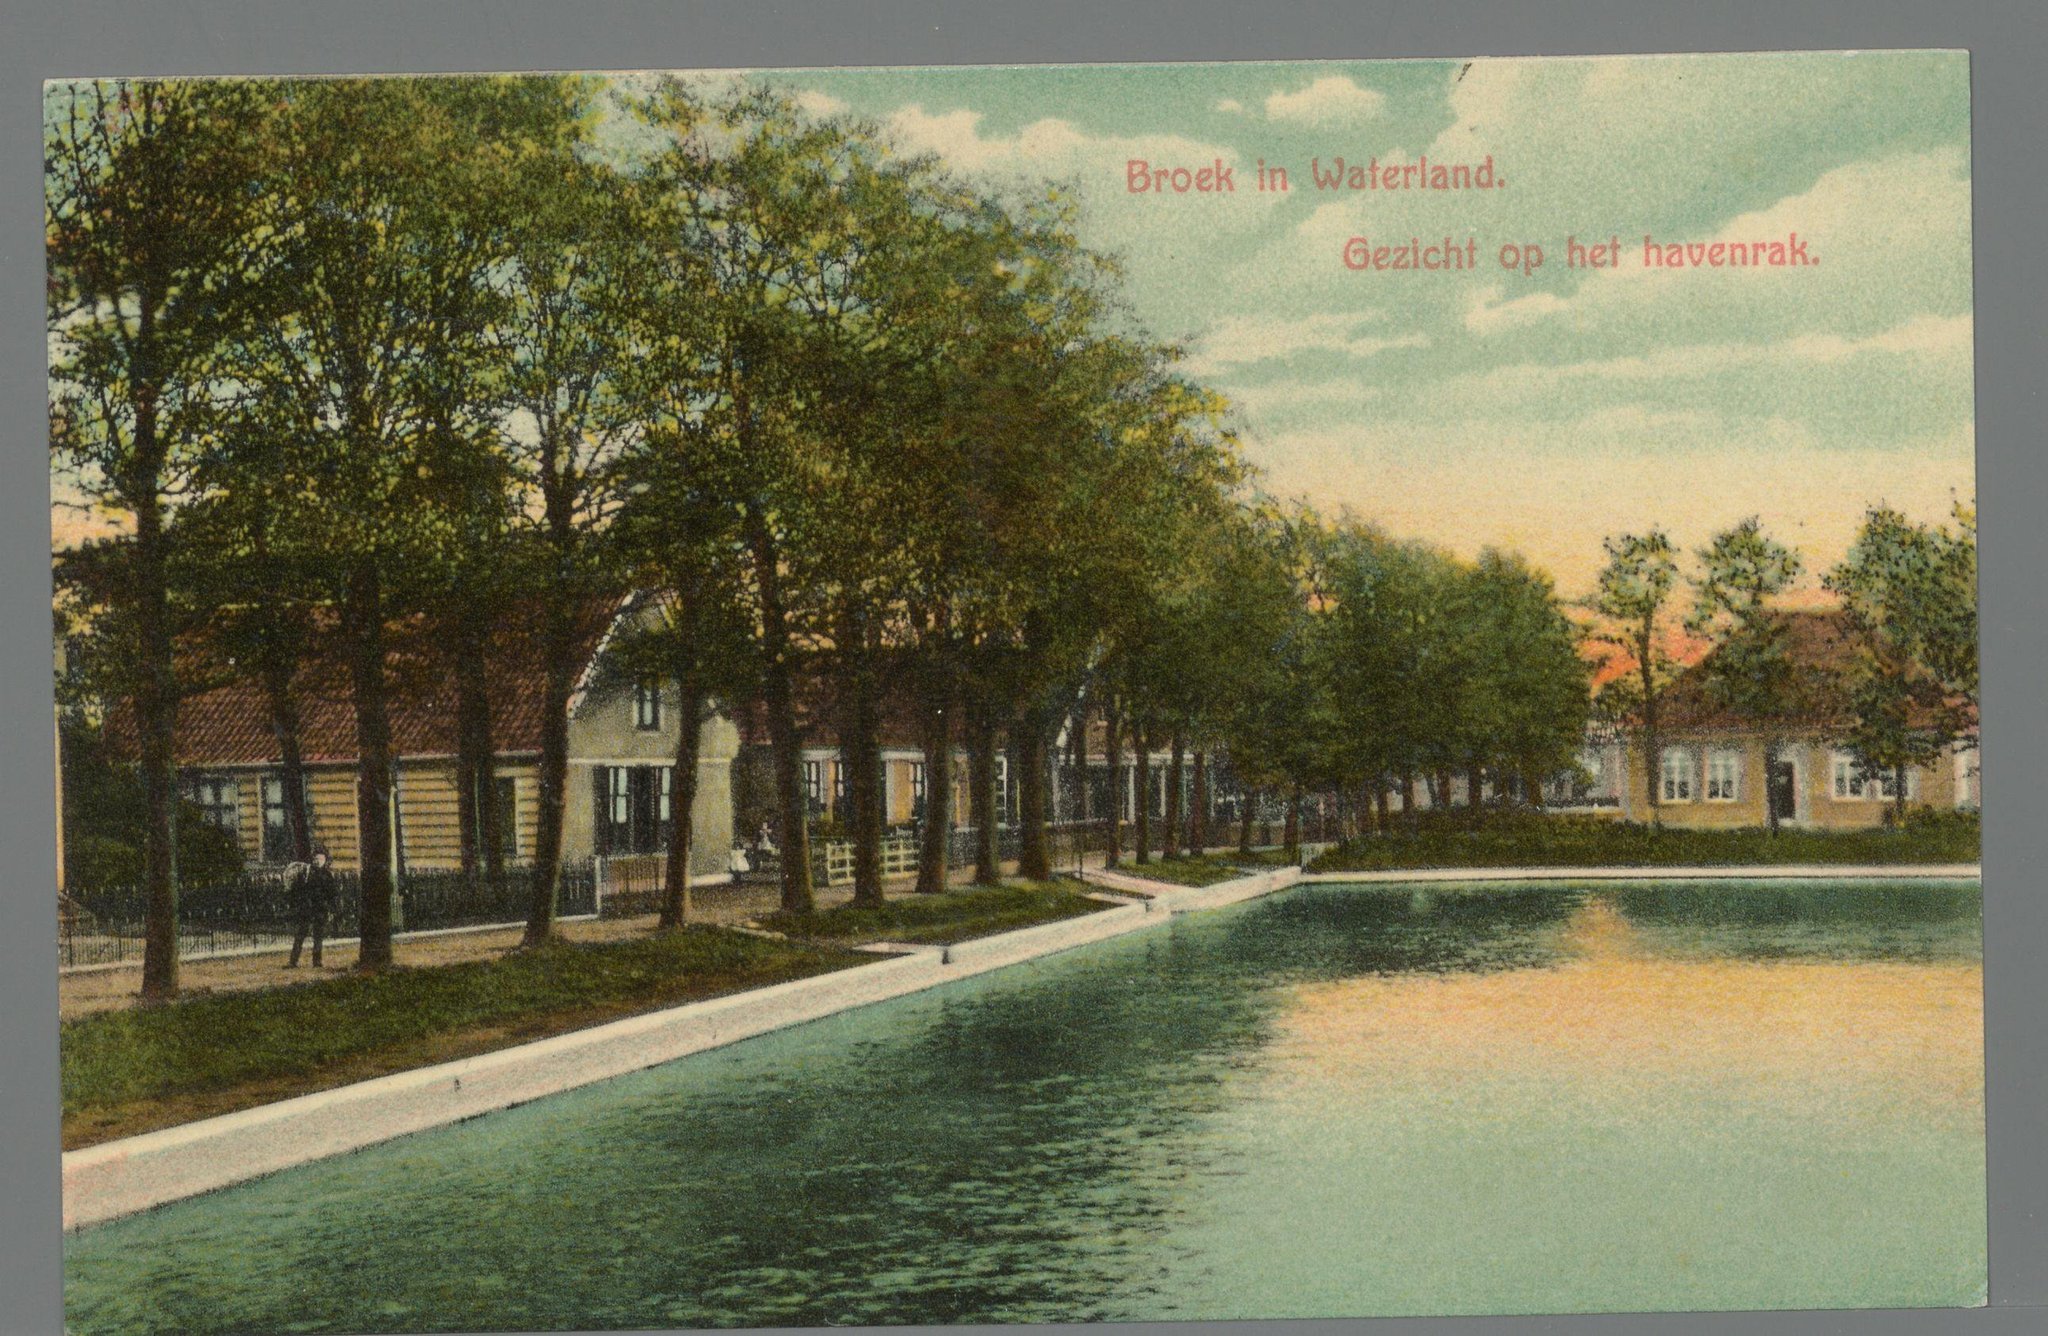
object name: photomechanical print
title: Broek in Waterland gezicht op het havenrak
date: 1906-1915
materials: cardboard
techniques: photograph, lithograph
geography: broek in waterland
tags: city-view, and landscape with man-made constructions, lake